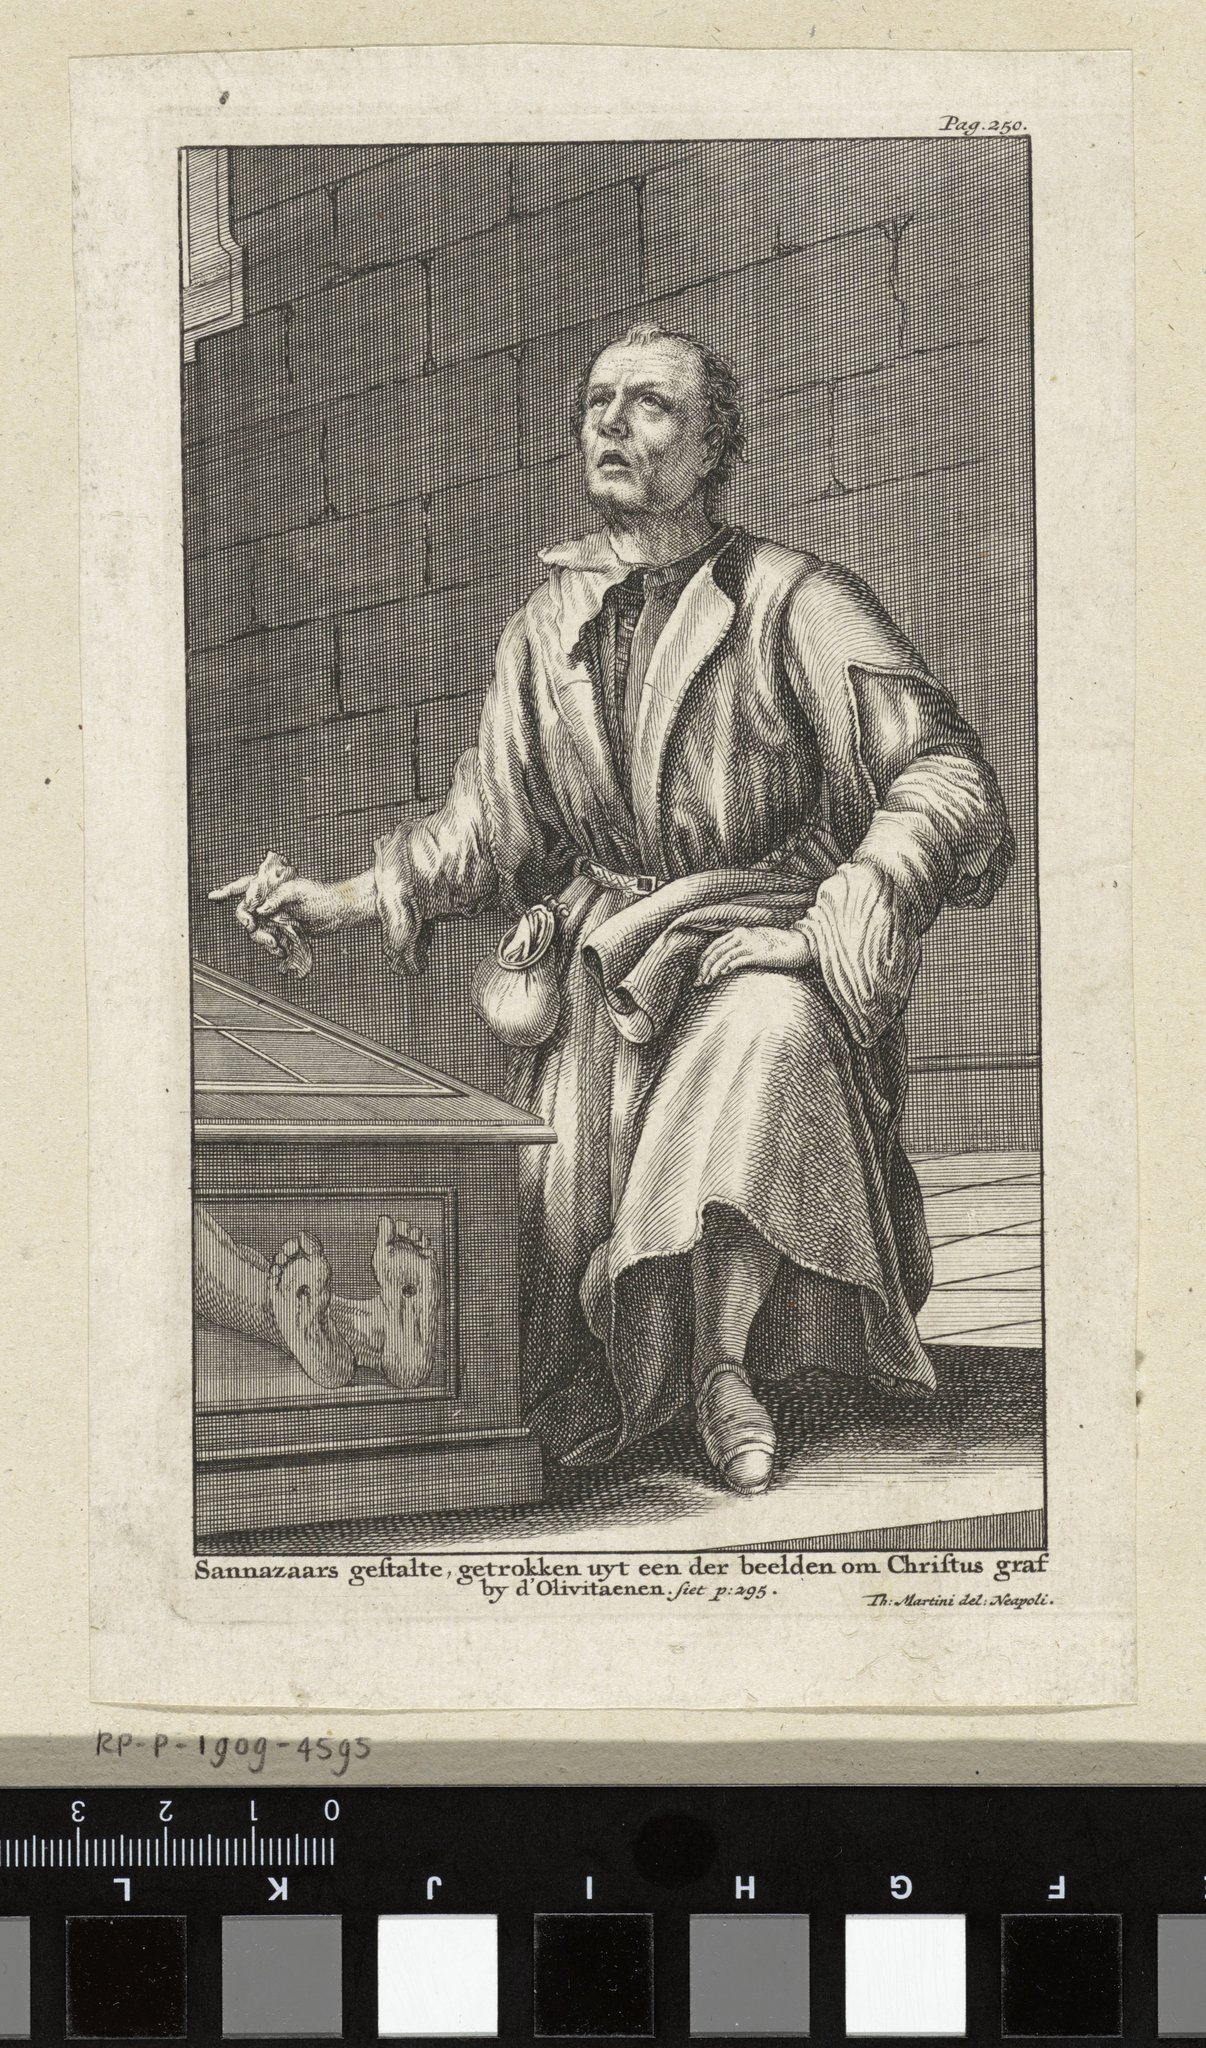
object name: print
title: Knielende man bij een graftombe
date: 1689-1730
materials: paper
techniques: engraving, etching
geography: naples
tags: rome, jacopo sannazaro, adult man, historical persons, grave, tomb, kneeling figure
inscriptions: collector's mark: Lugt 2228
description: Bij een graftombe in een kerk of kapel knielt een man, mogelijk Jacopo Sannazaro. Onder de voorstelling een tweeregelig onderschrift in het Nederlands en de pagina-aanduiding 295. Rechtsboven: Pag. 250.